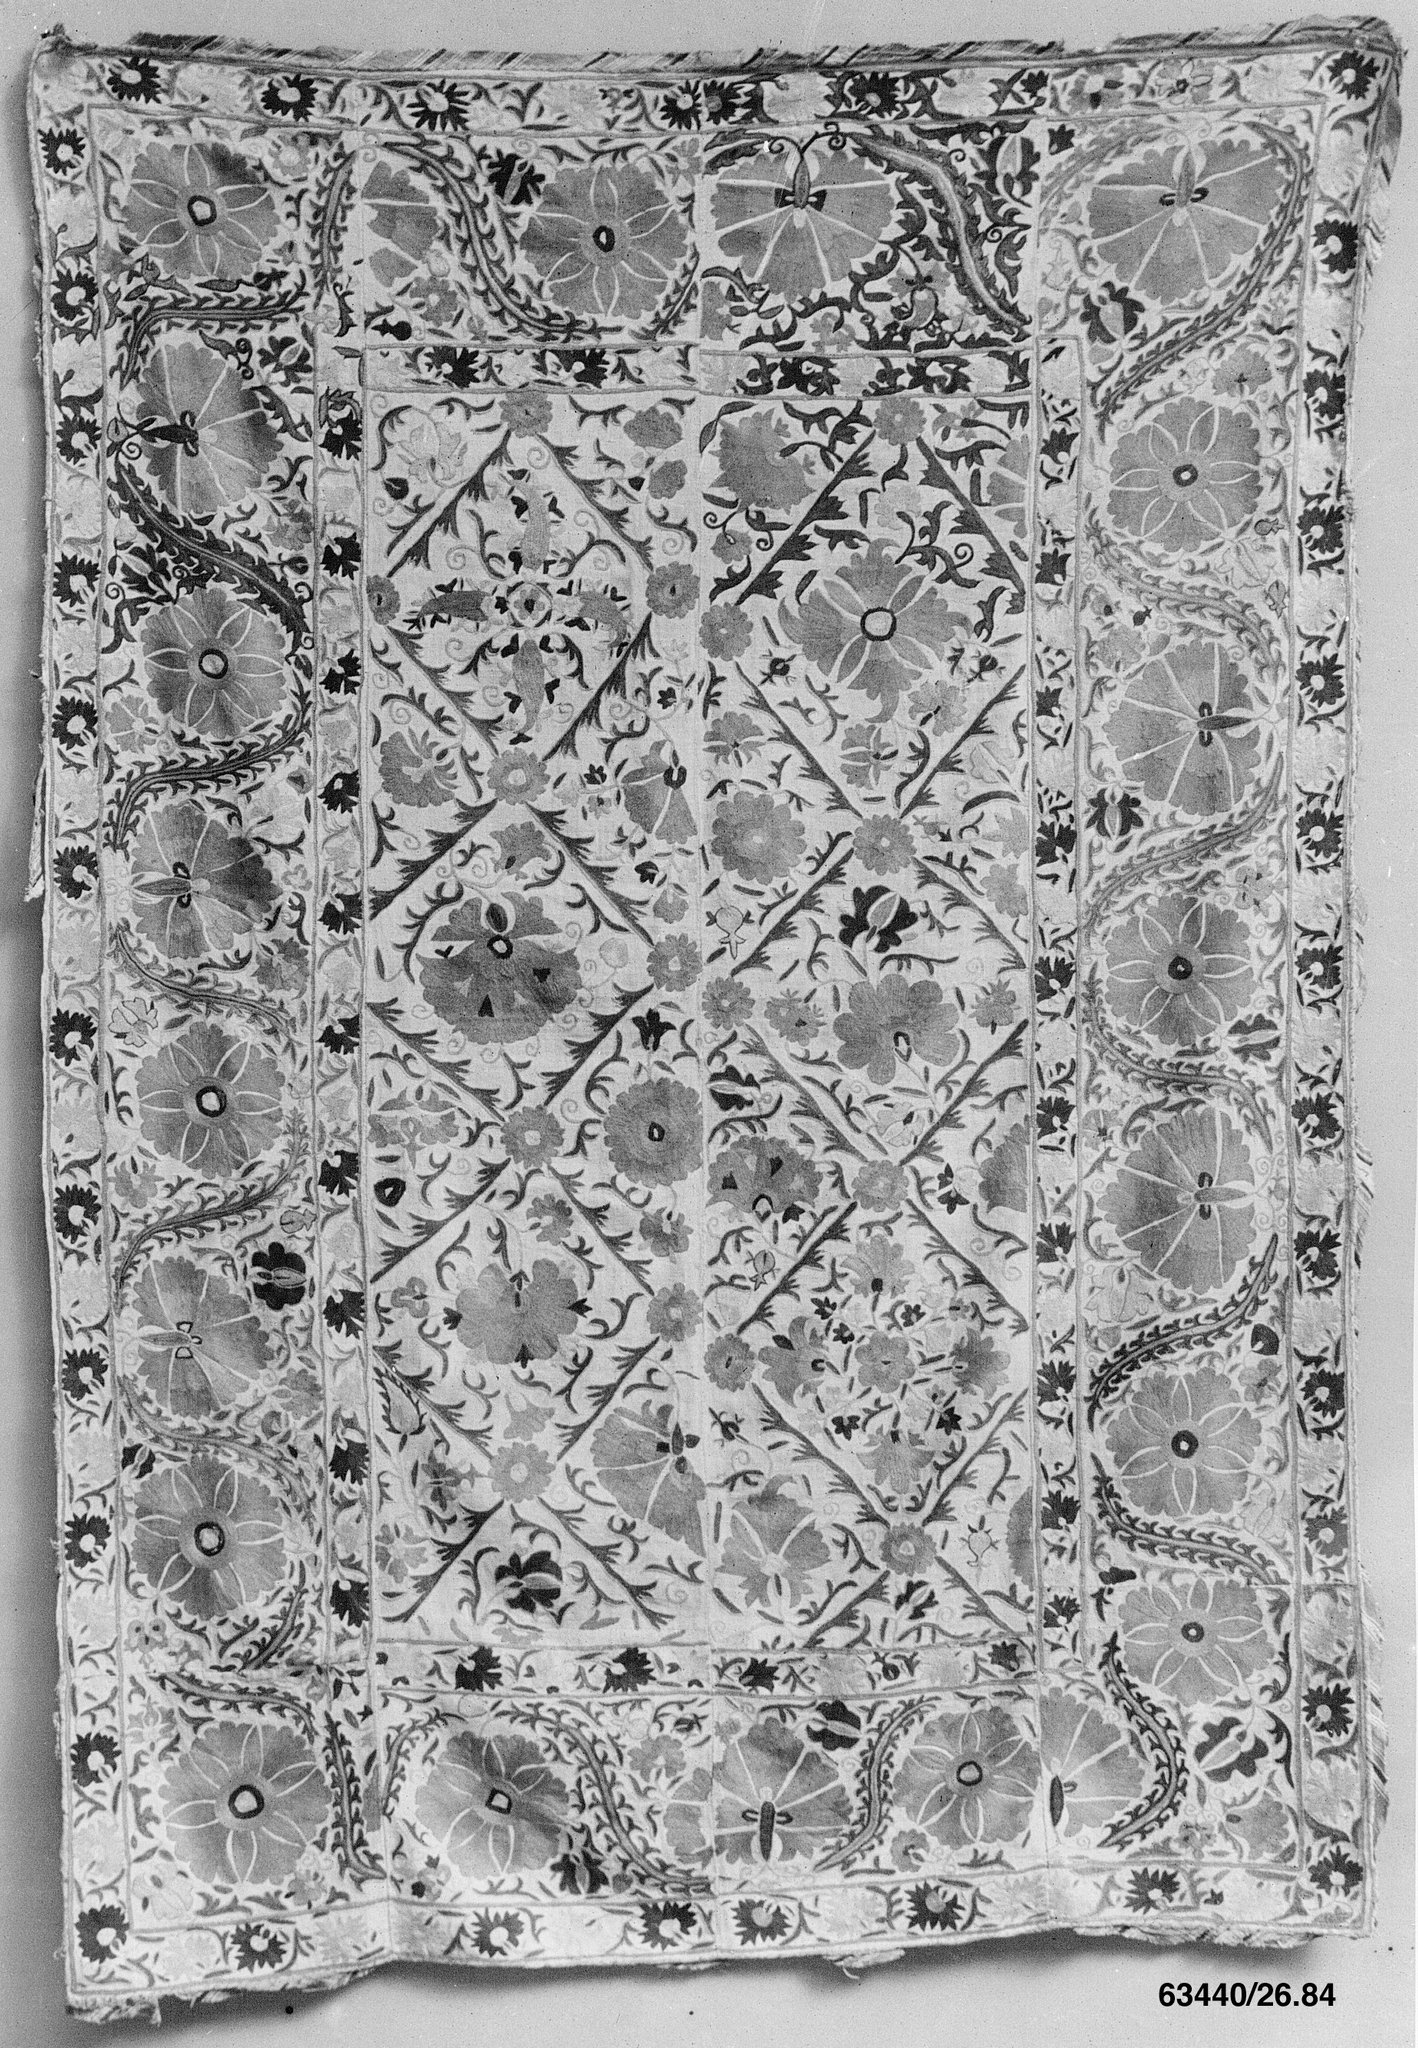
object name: hanging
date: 1701-1800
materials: linen, silk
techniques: embroidery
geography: uzbekistan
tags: flowers